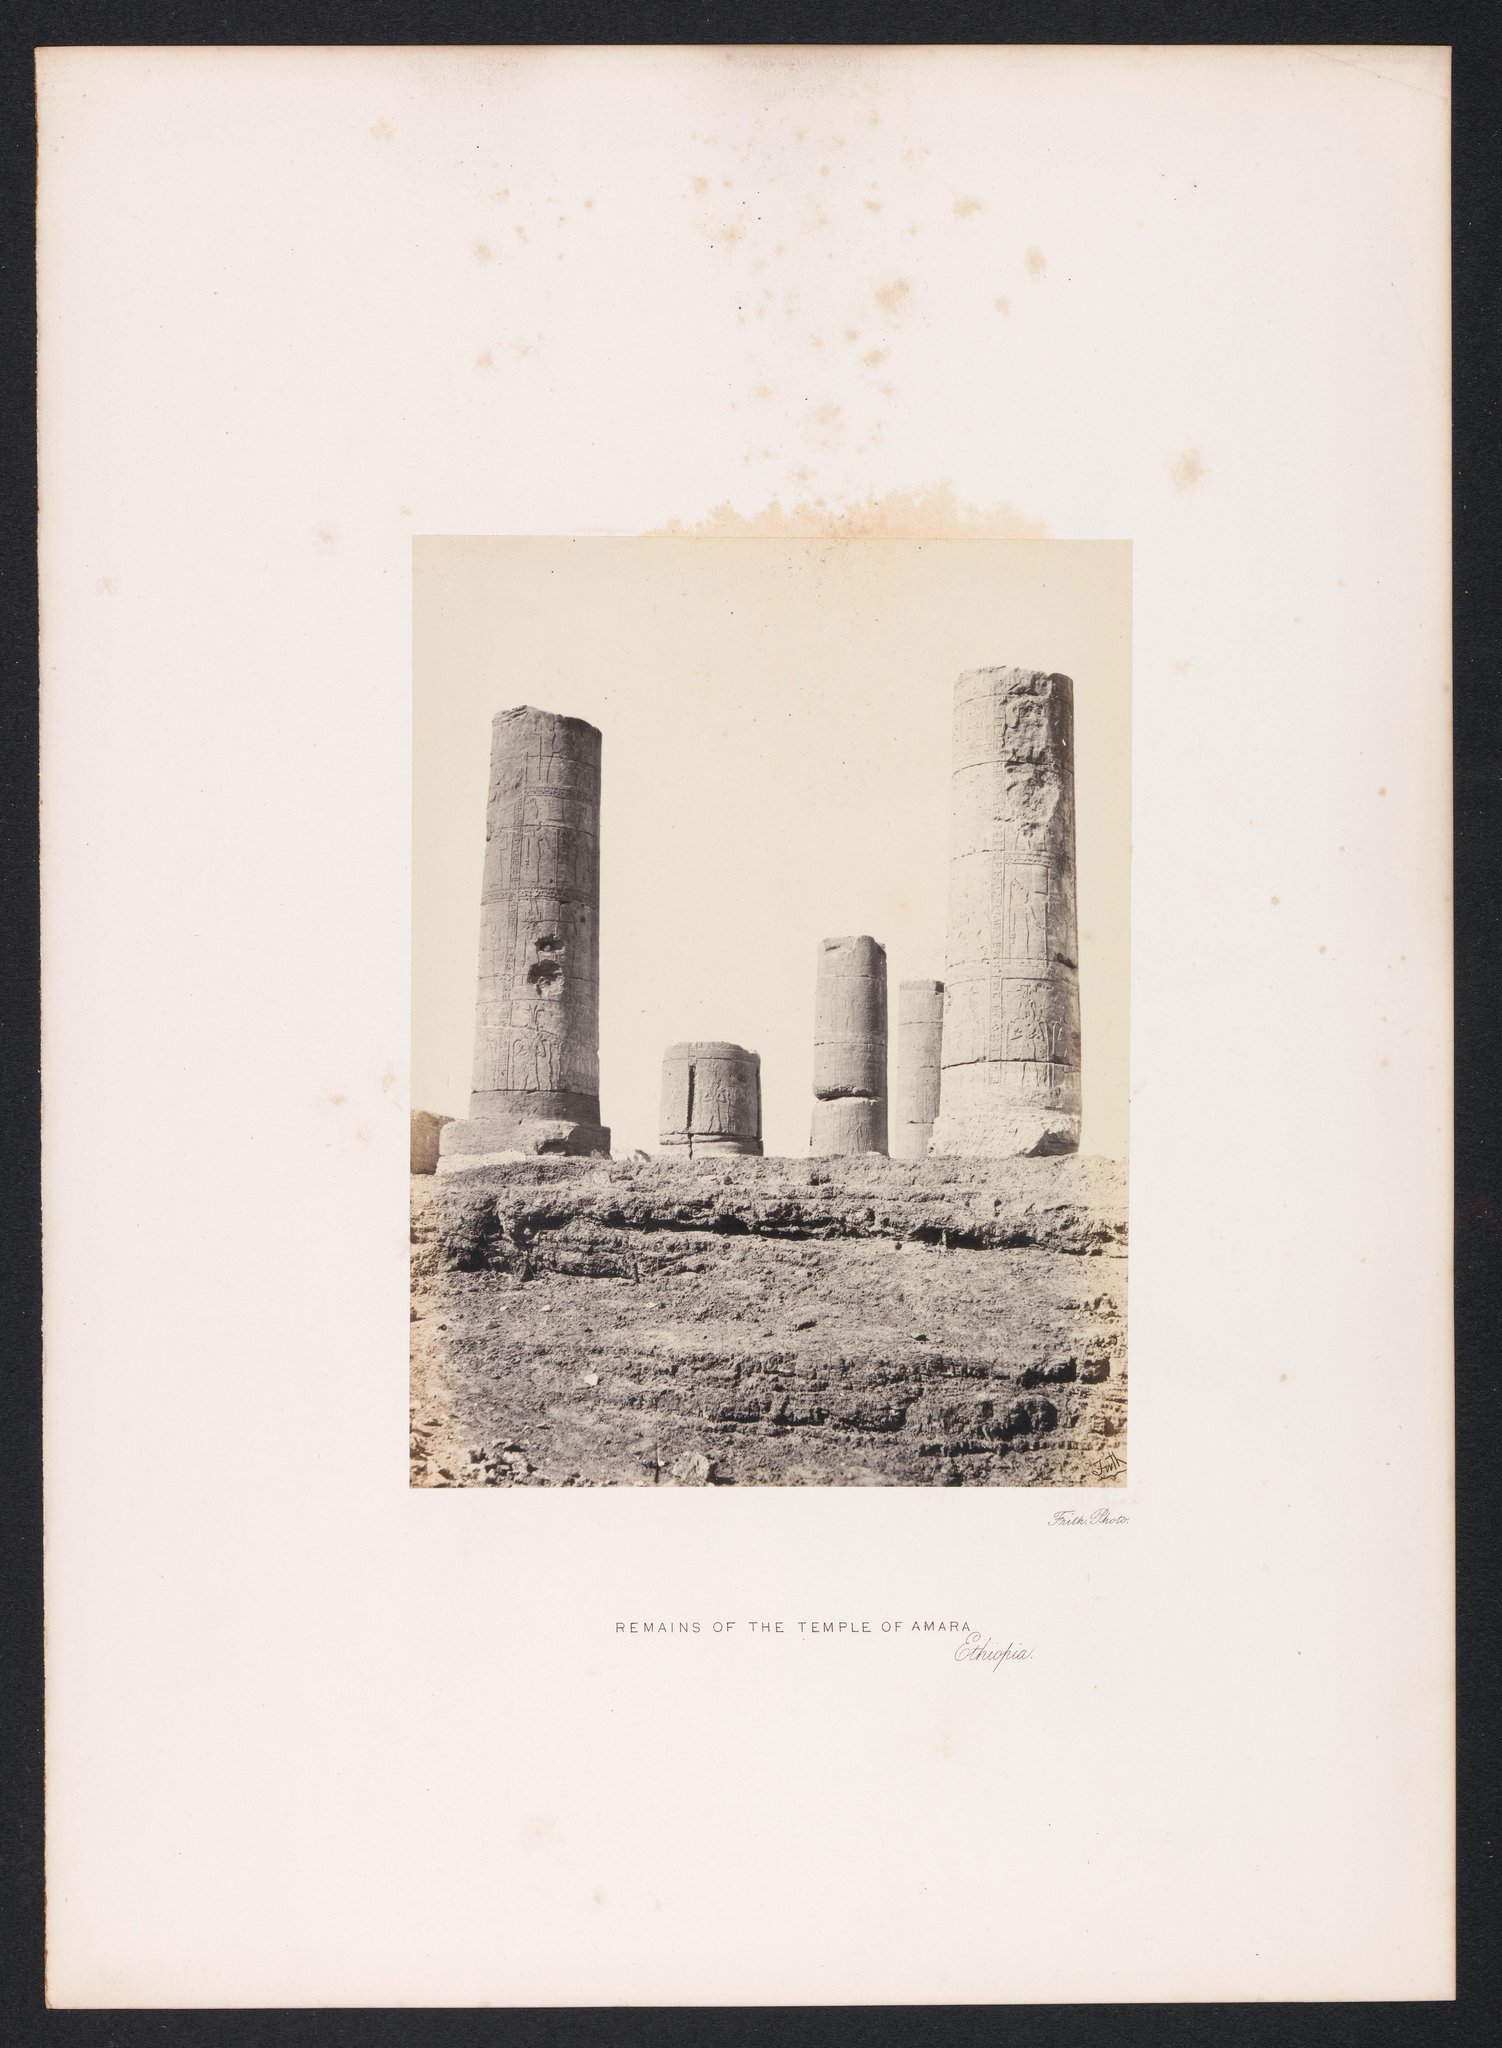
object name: photograph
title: Restanten van de tempel van Amara in Ethiopië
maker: francis frith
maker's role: publisher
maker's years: 1822-1898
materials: paper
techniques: albumen print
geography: ethiopia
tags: ruin of a building ~ architecture